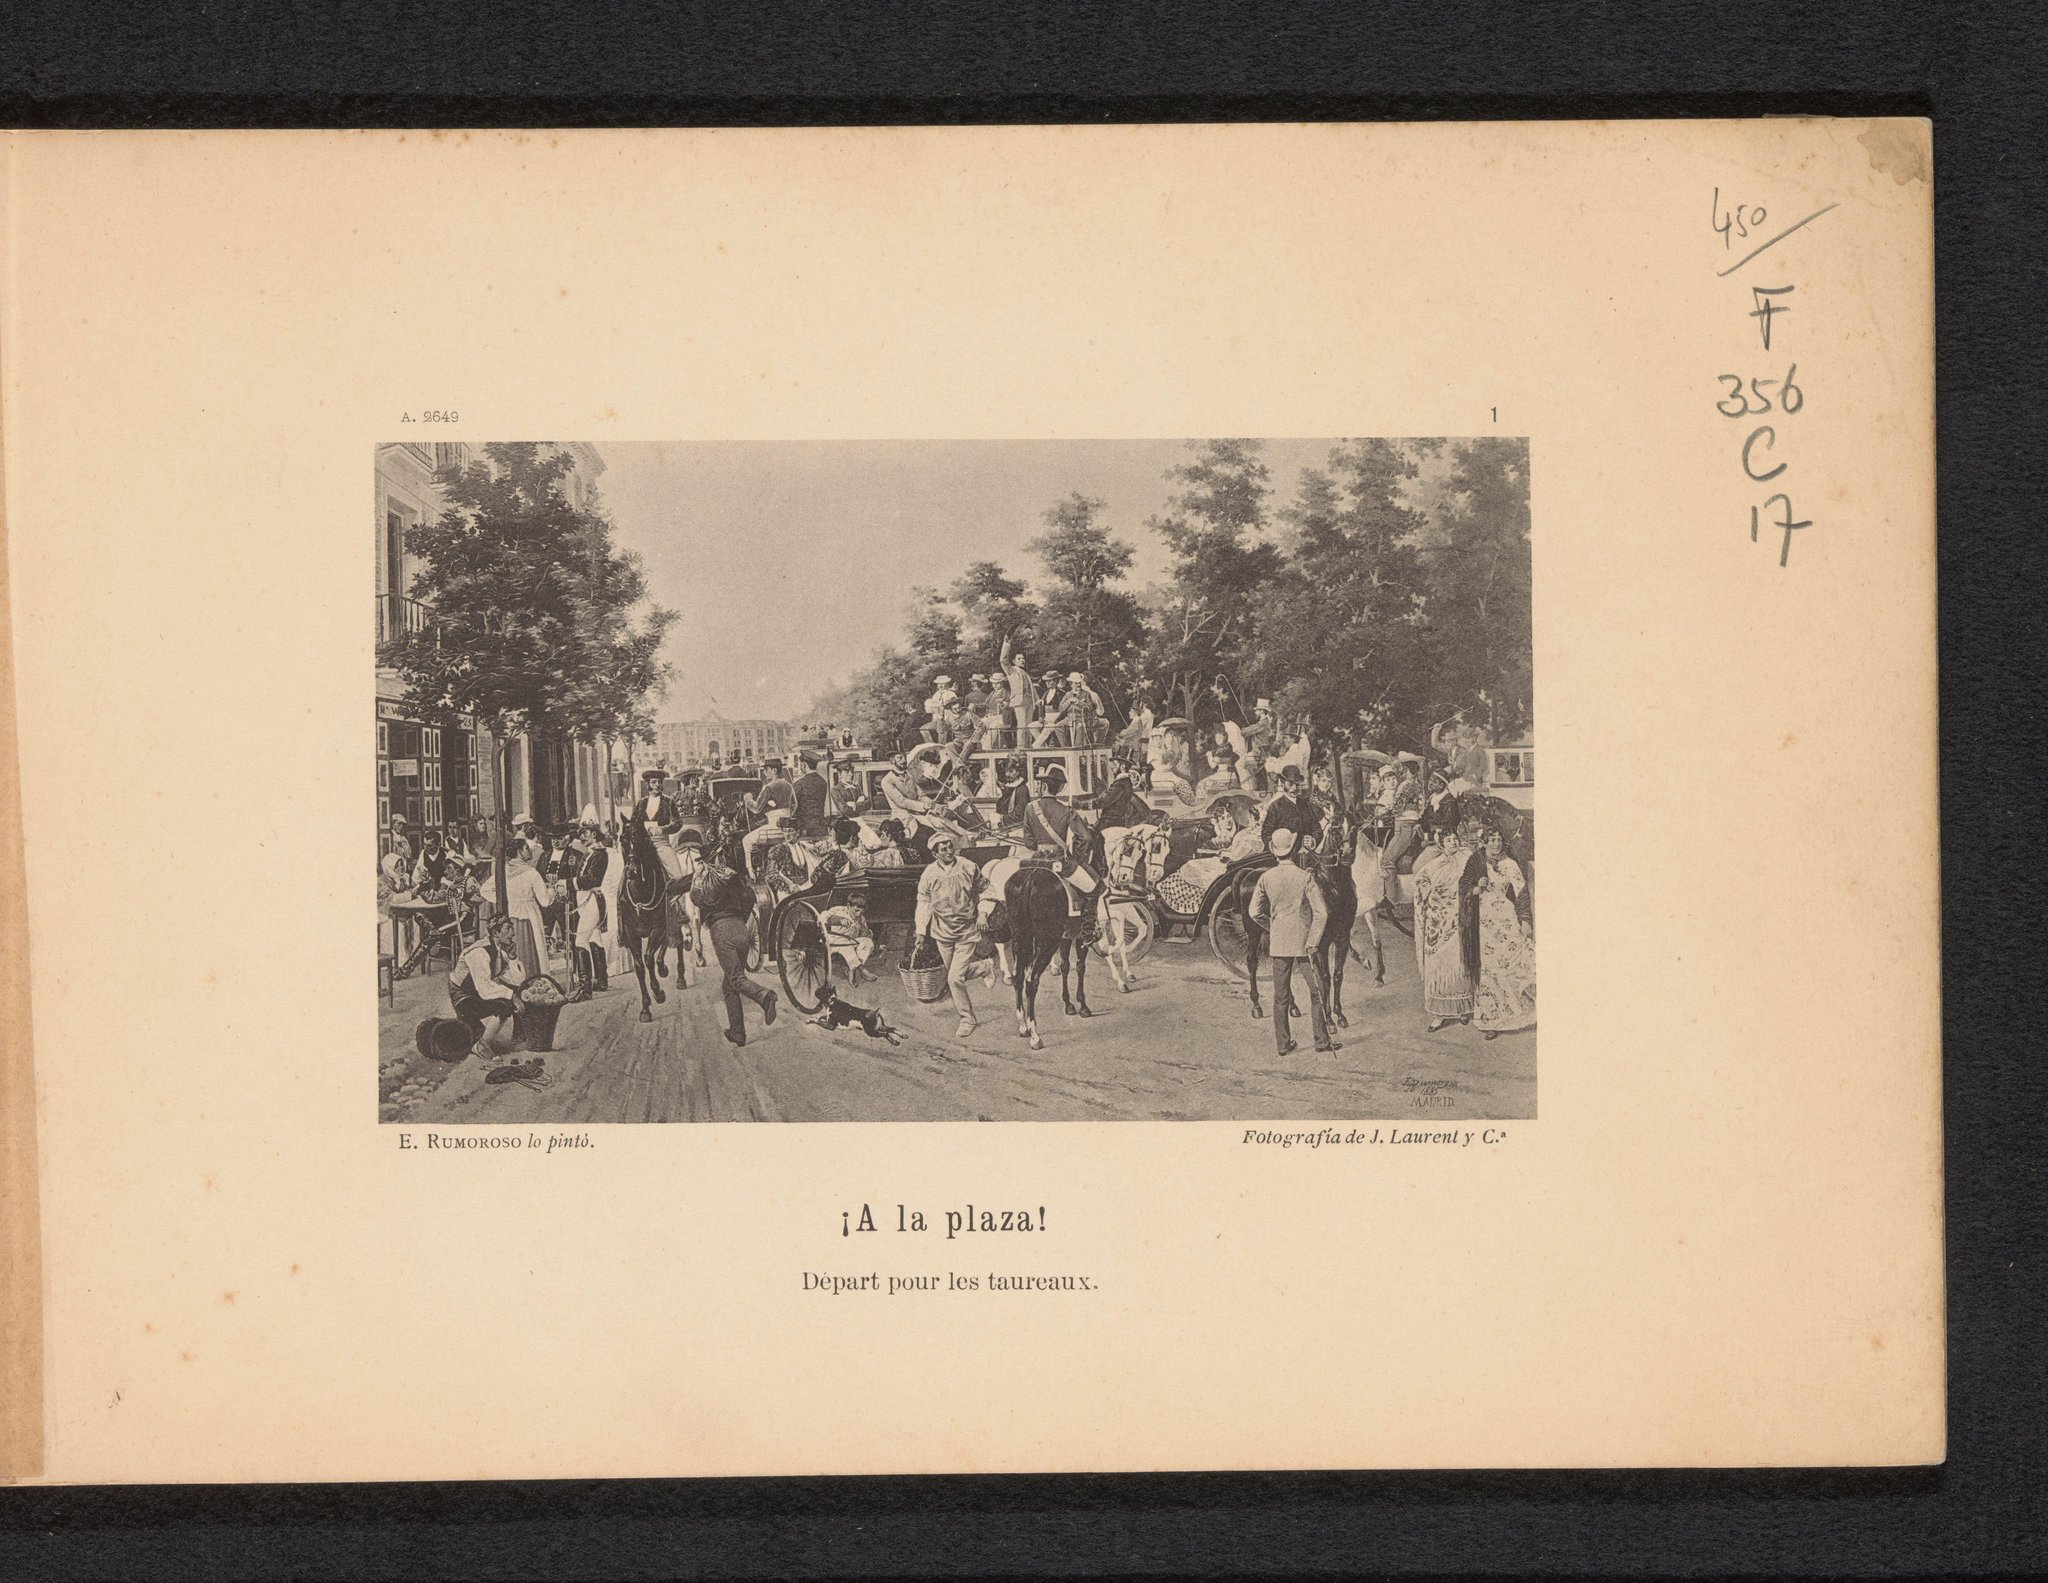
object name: photomechanical print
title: ¡ A la plaza!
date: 1880-1890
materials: paper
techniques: photograph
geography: spain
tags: bullfight, four-wheeled, animal-drawn vehicle, e.g.: cab, carriage, coach, theatre (building) - aa - open-air performances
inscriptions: number: ‘A. 2649’